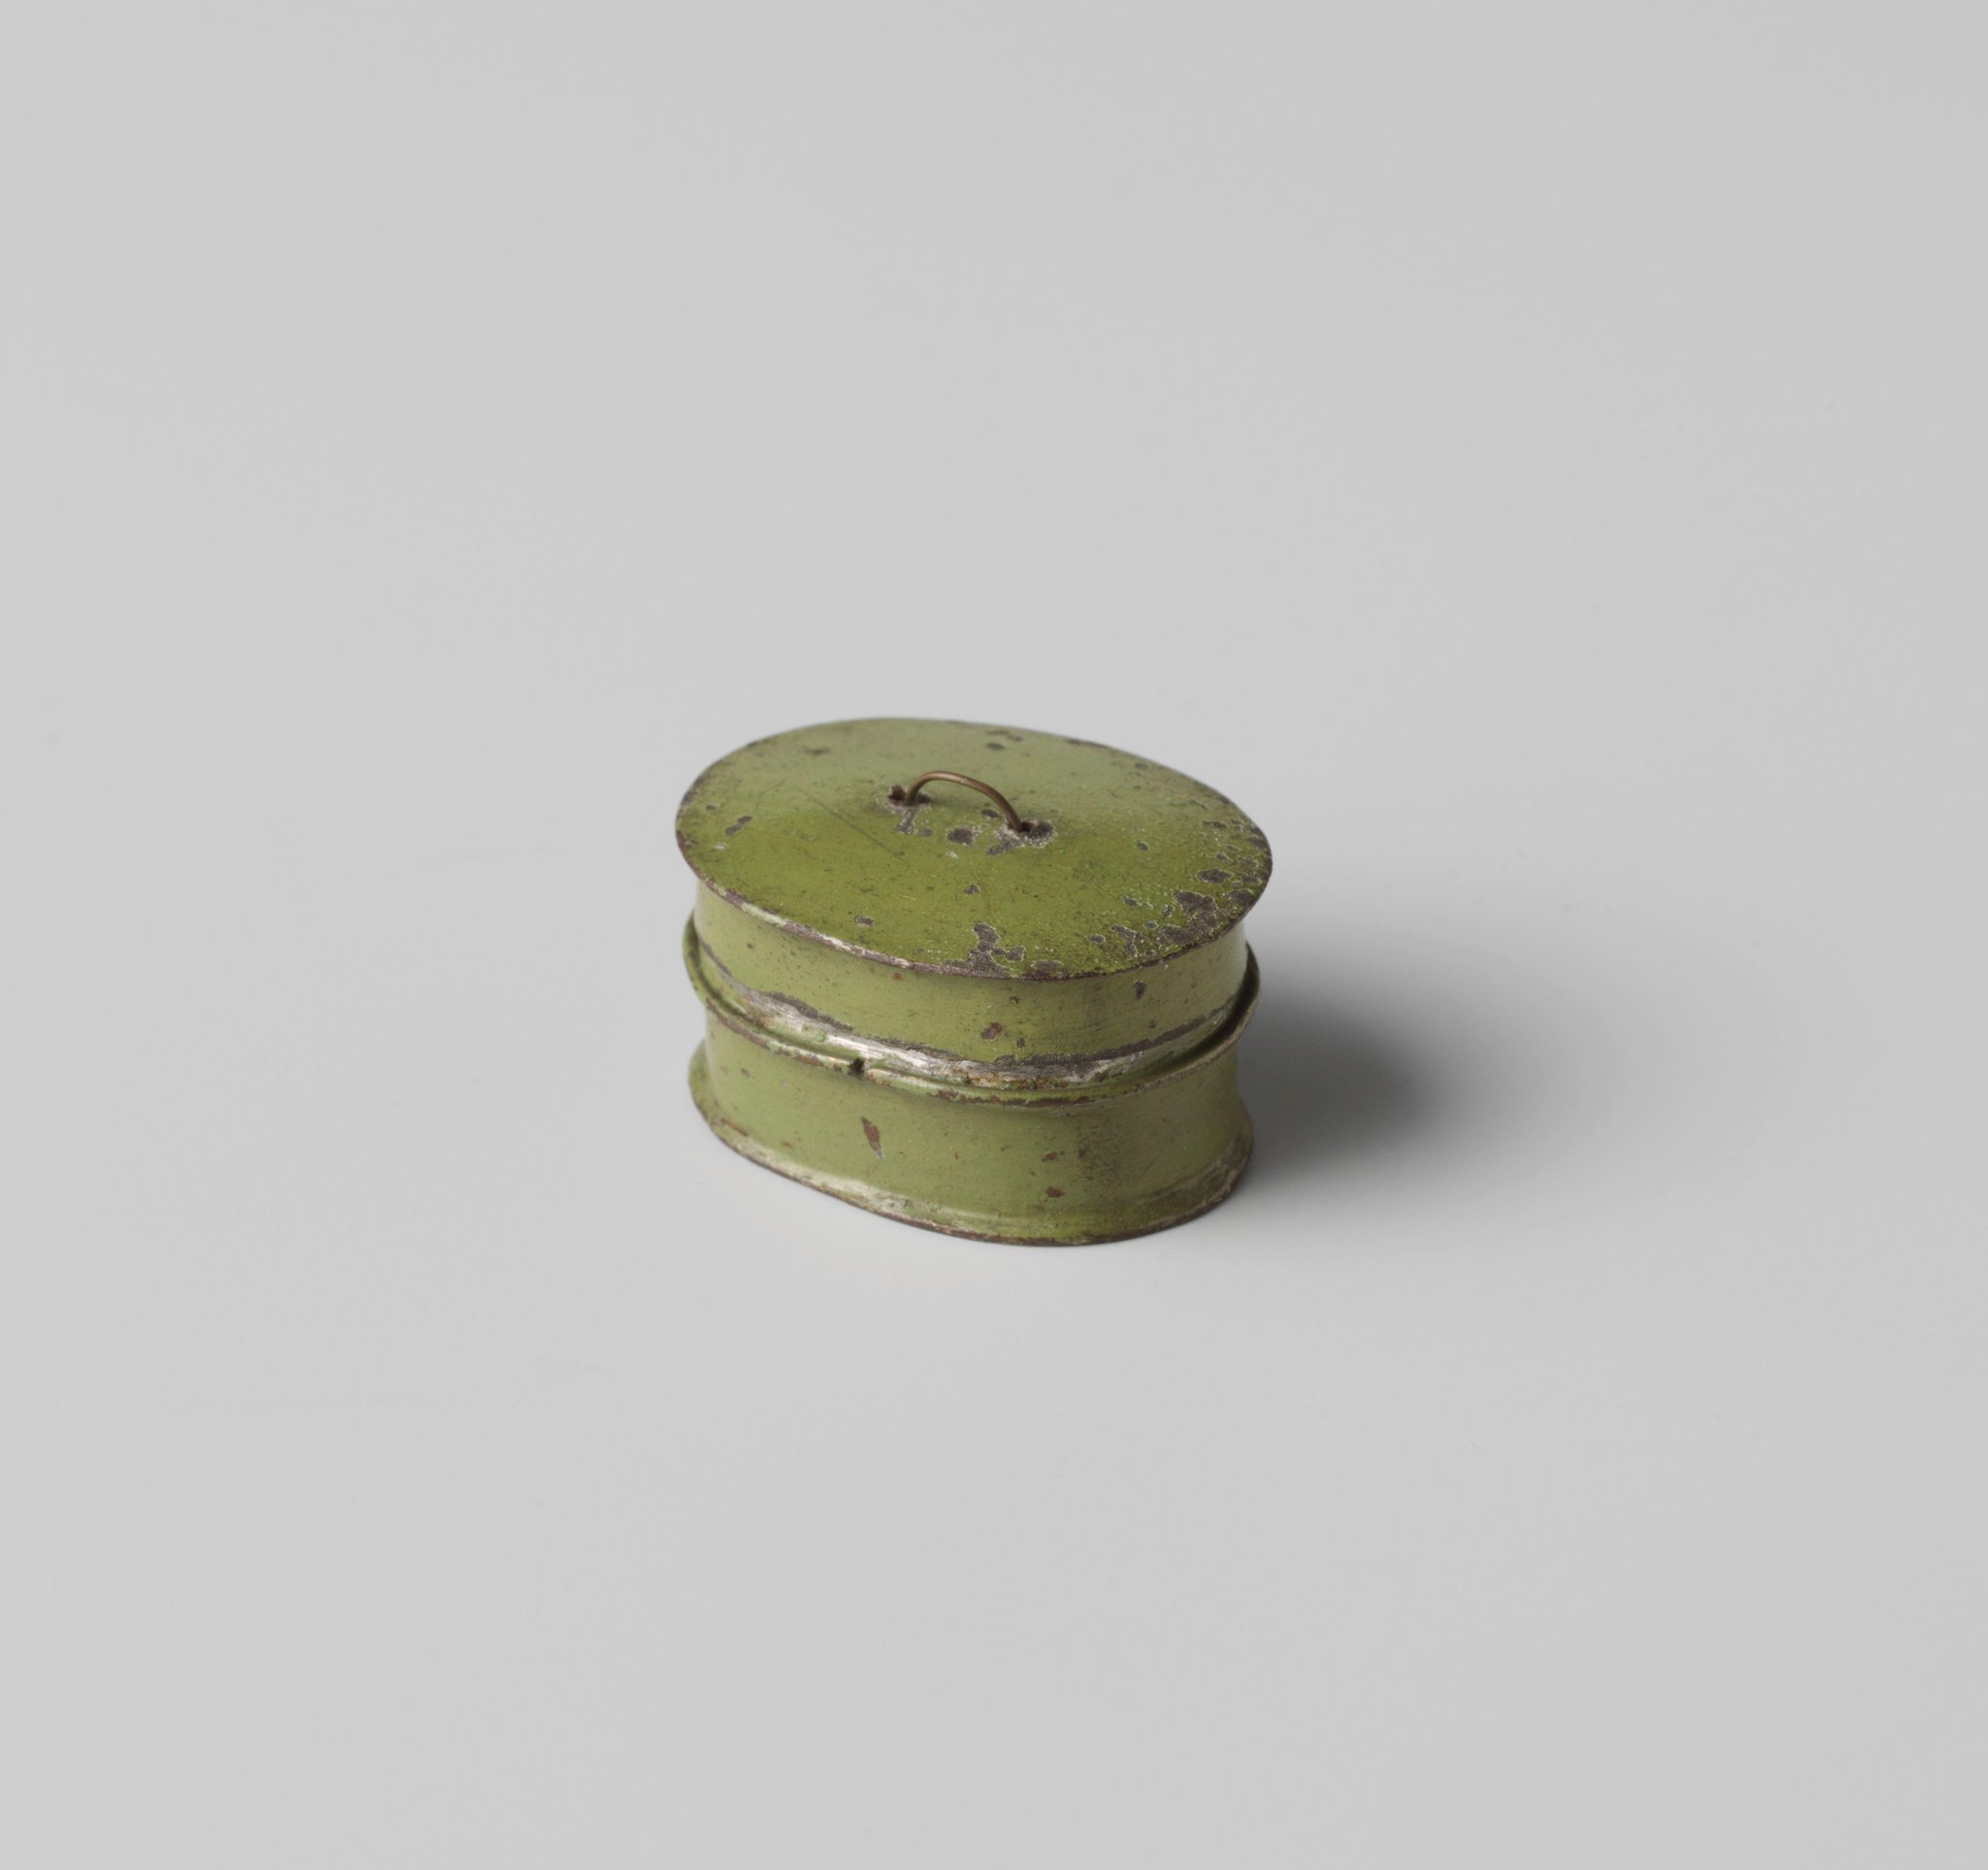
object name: tin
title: Trommel met deksel, ovaal, groengeverfd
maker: Anonymous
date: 1700-1799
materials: metal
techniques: painted, tinning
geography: amsterdam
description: Een ovale, groengeverfde blikken trommel met scharnierende deksel met los in deksel aangebracht handvat; van binnen vertind.